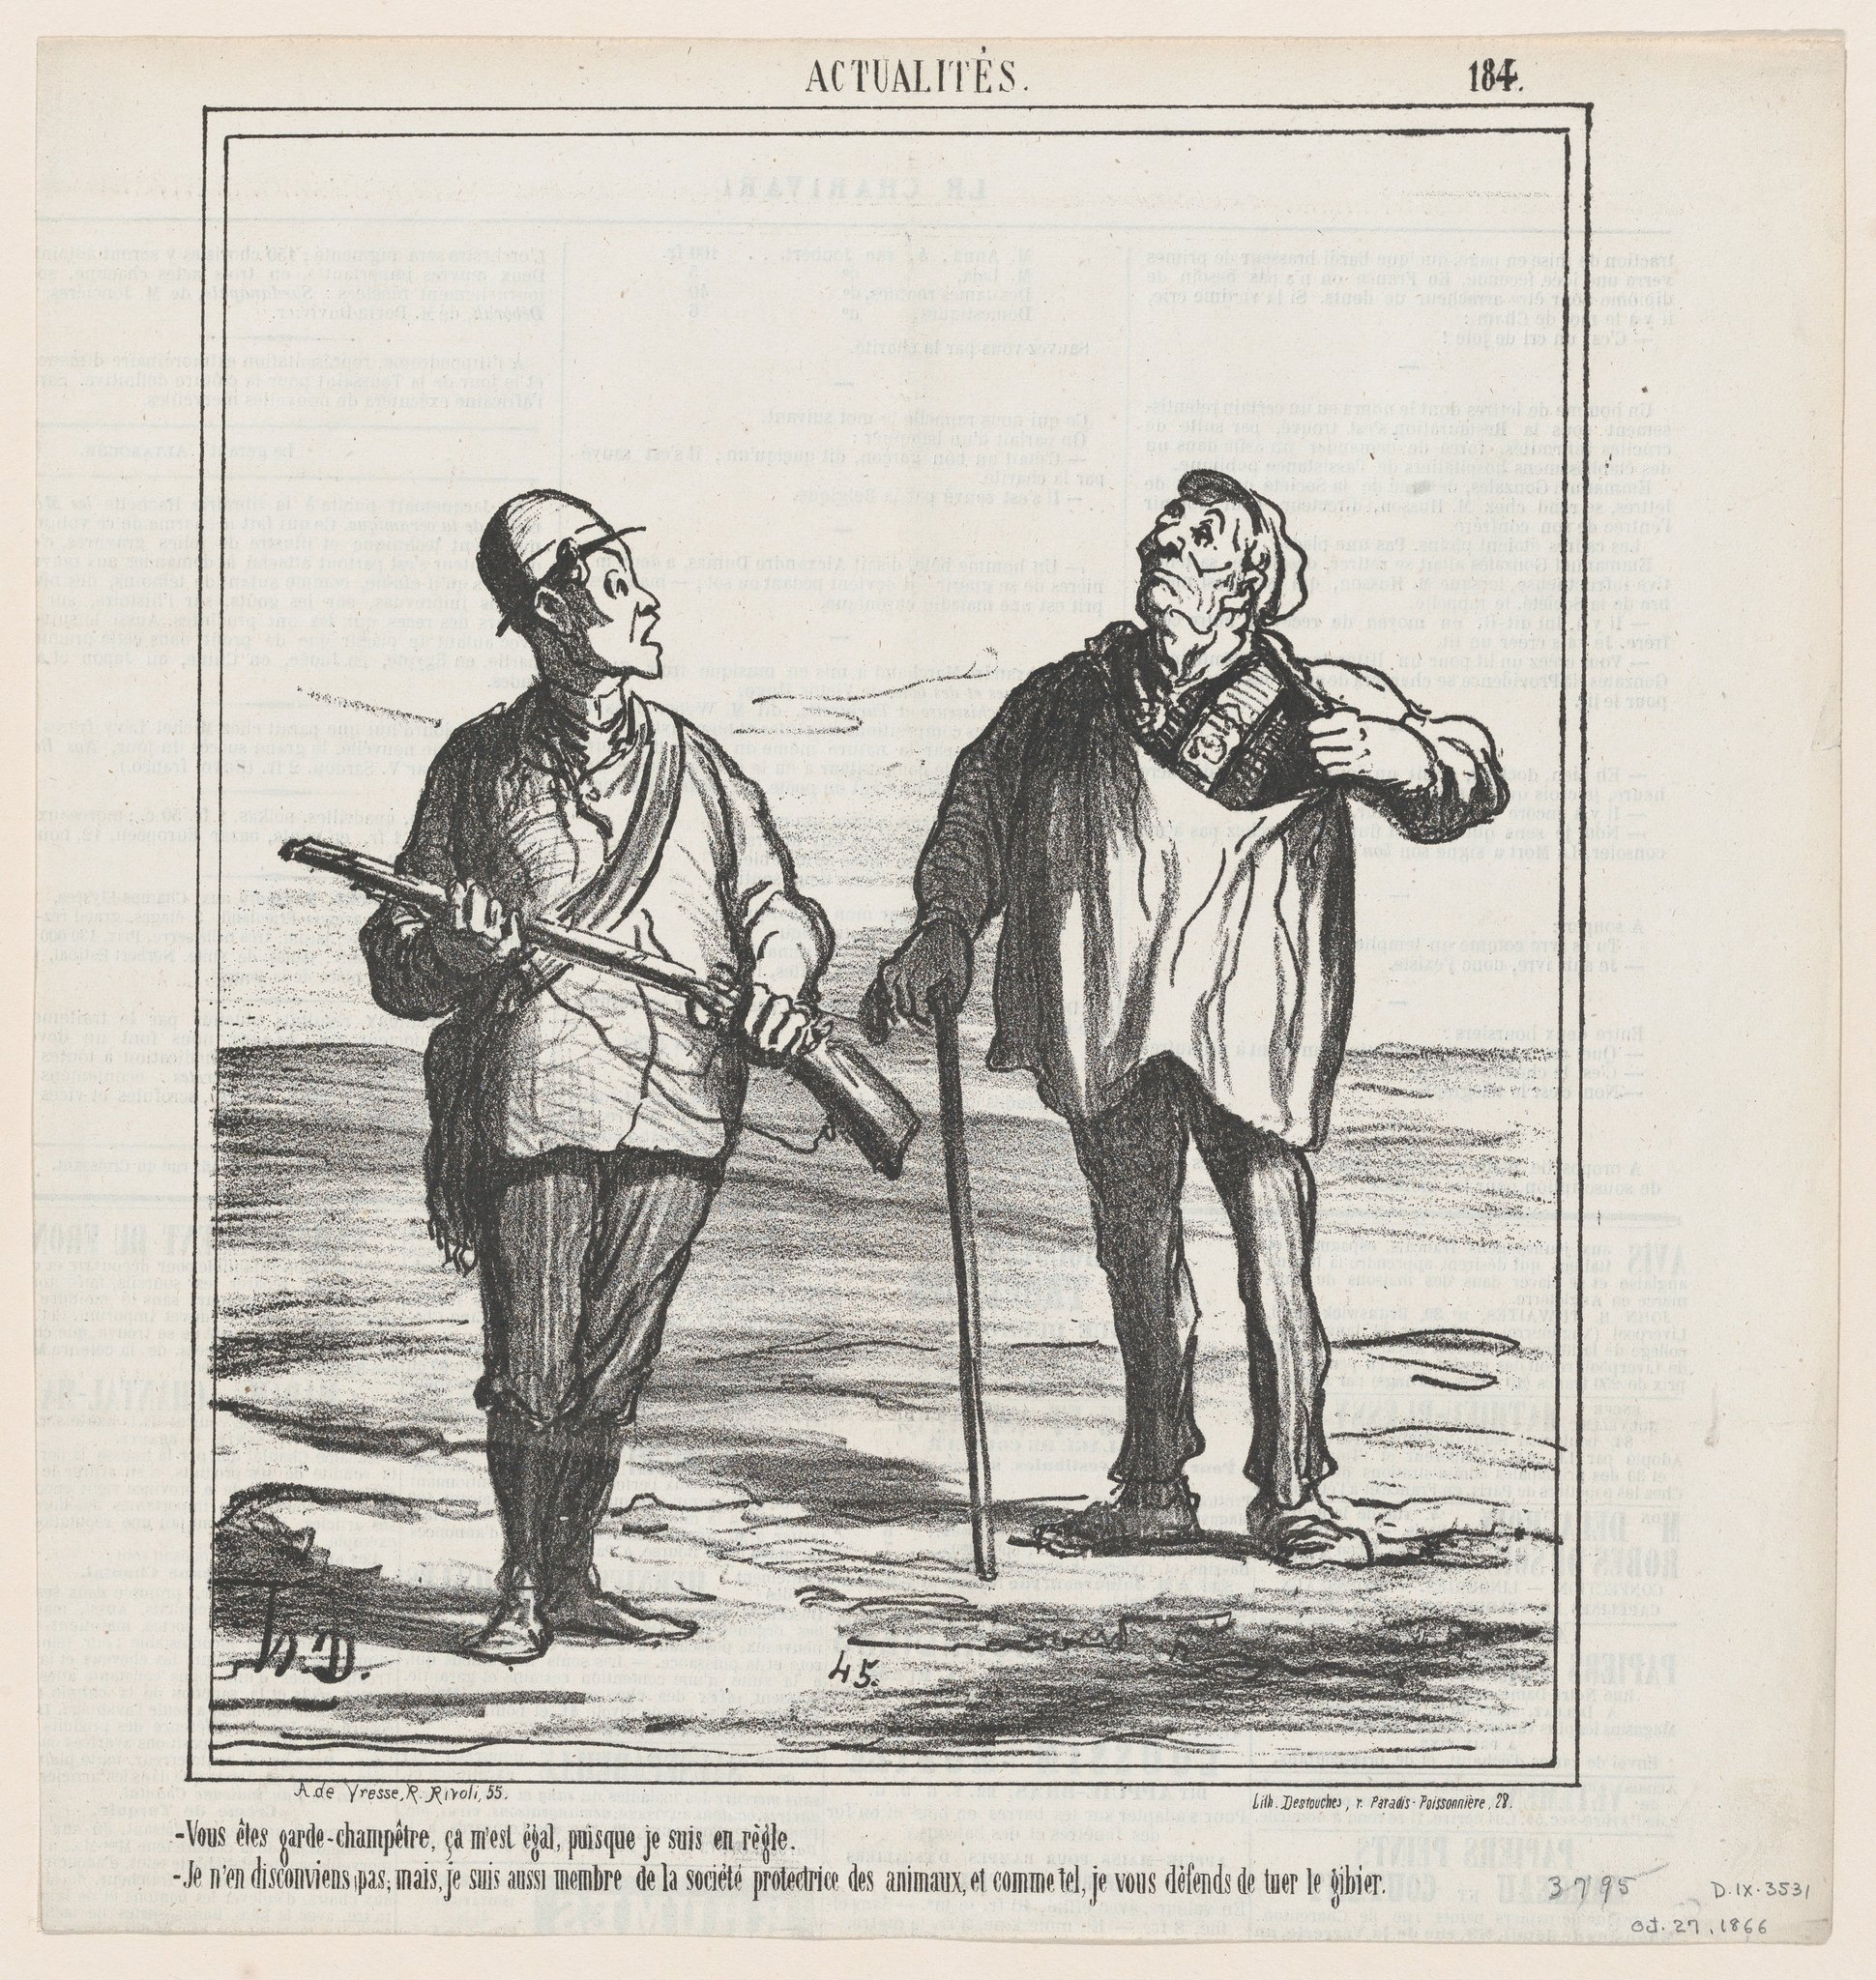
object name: print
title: You are a warden, it is all right for me since I have a license, from "News of the day"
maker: honoré daumier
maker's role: artist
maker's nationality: french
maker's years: 1808-1879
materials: paper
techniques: lithograph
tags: satire,firearms,men